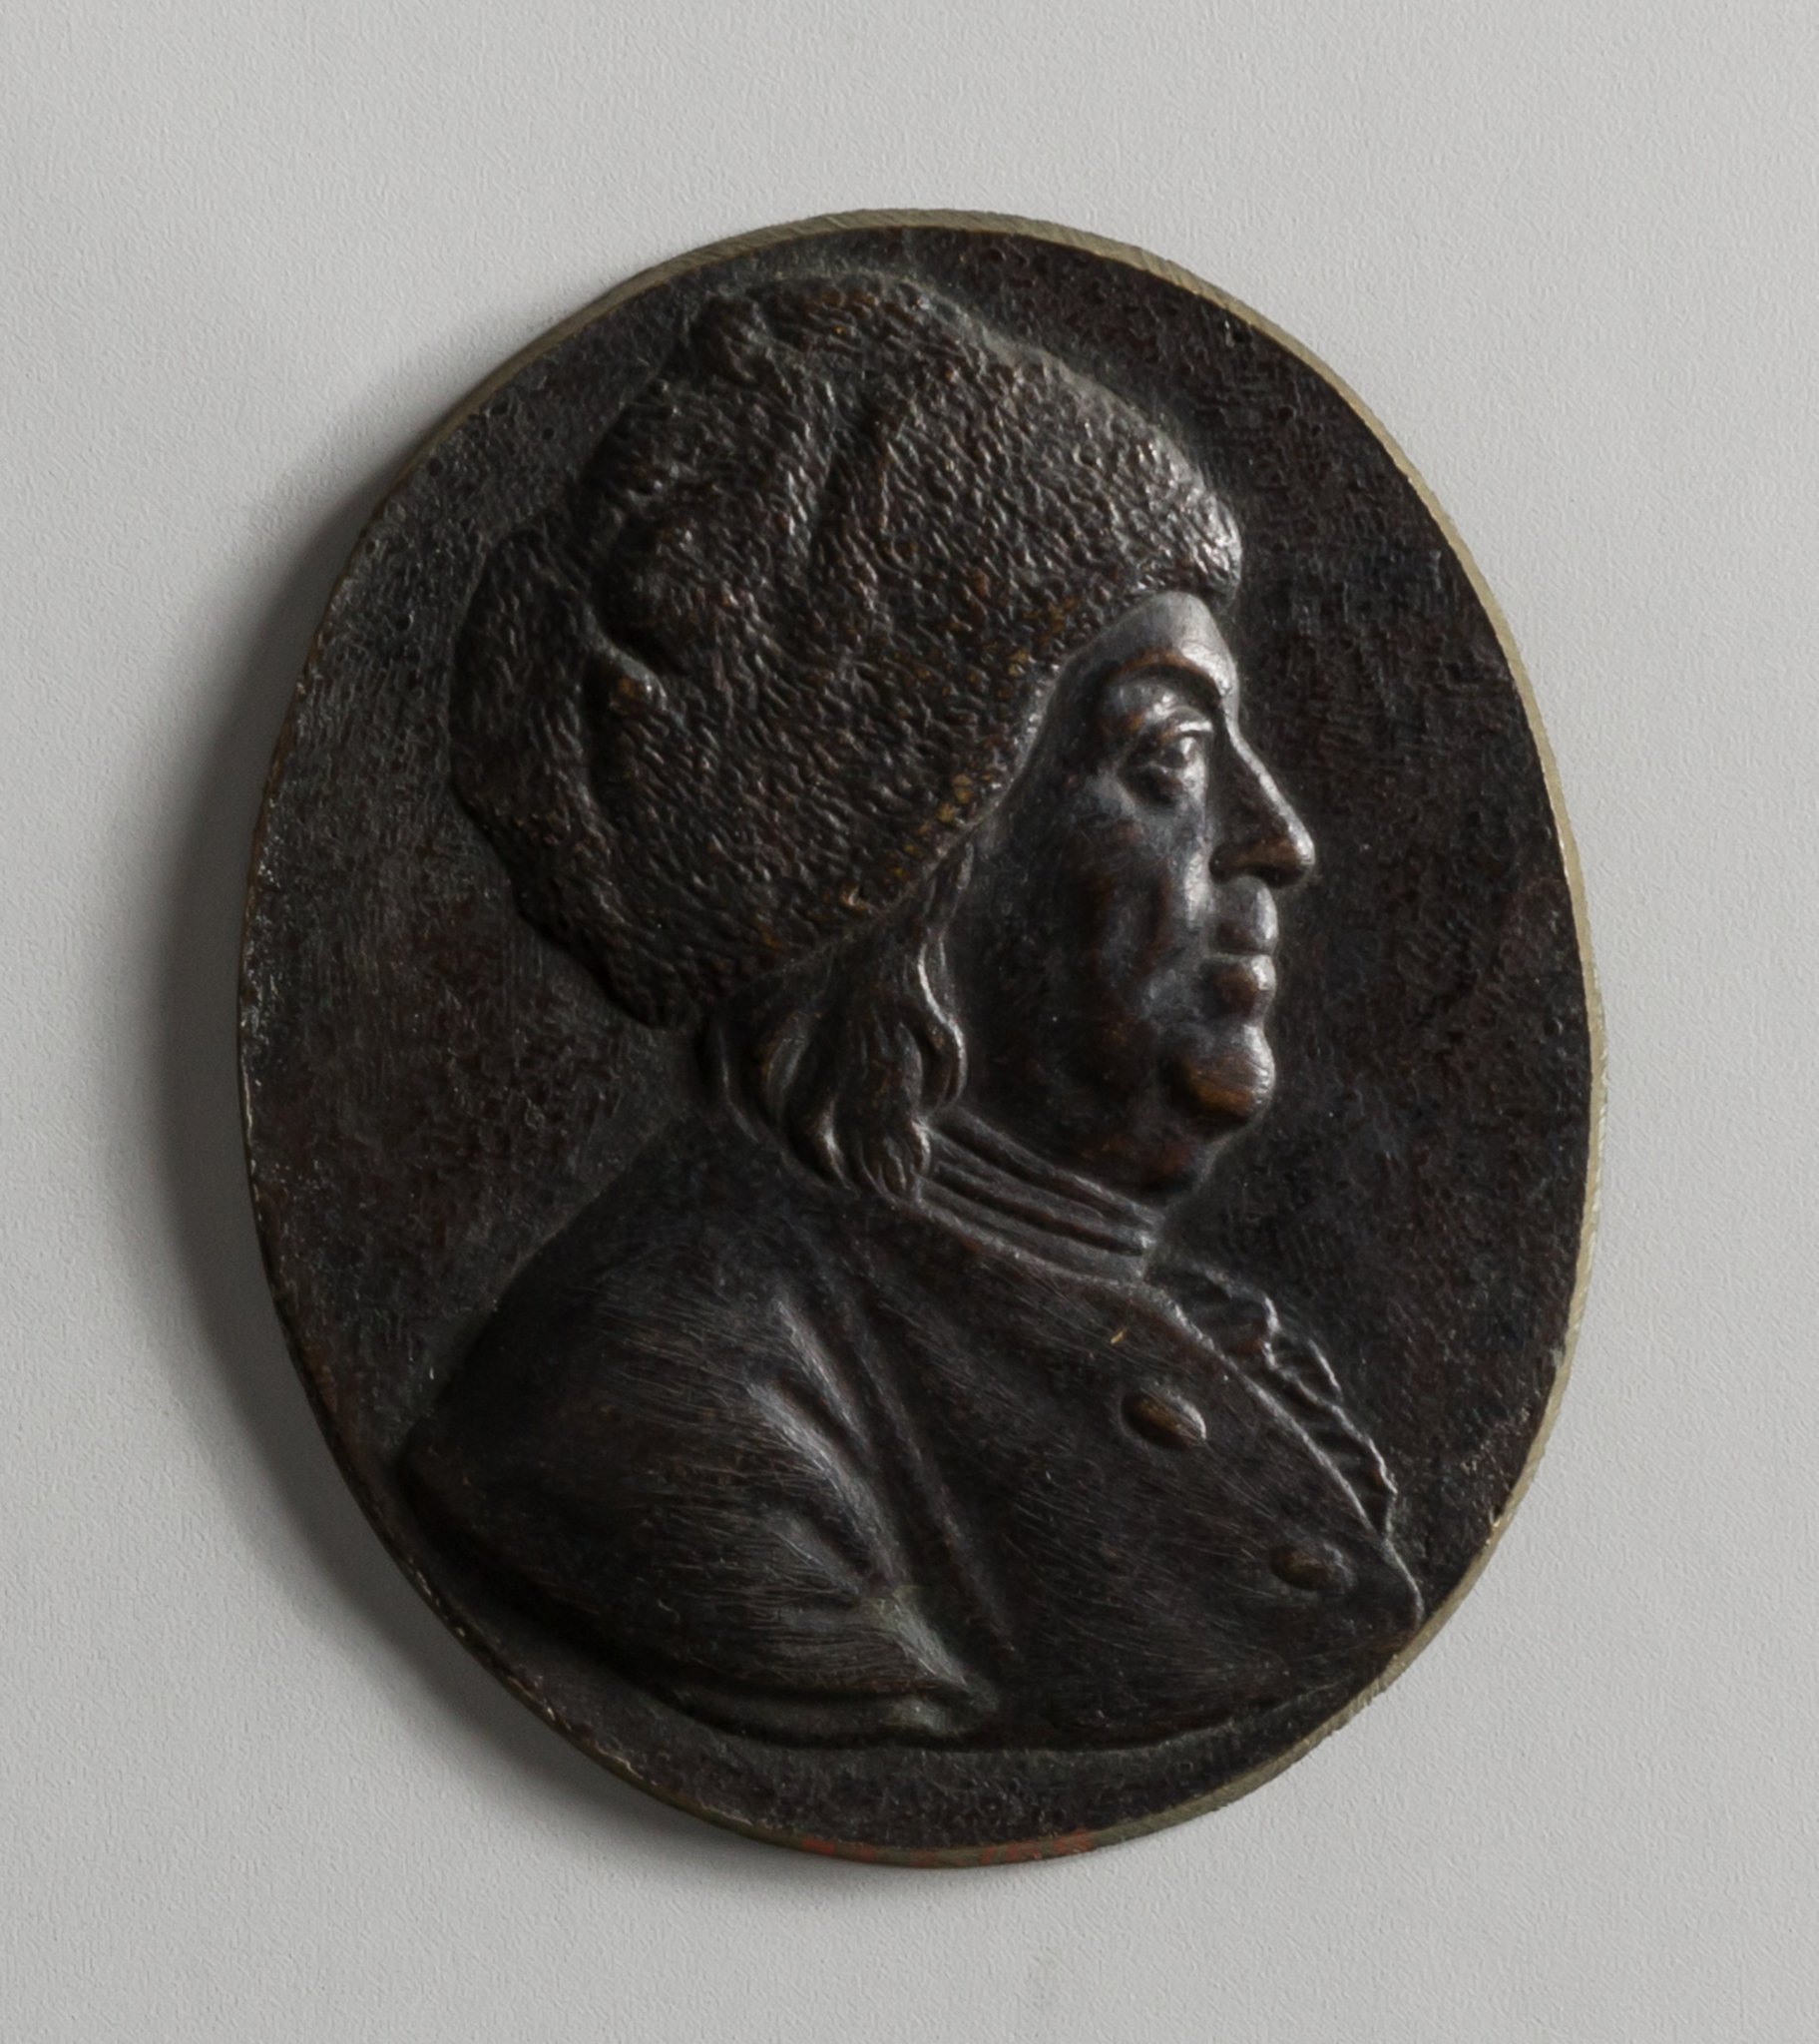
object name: medallion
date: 1776-1883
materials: bronze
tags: benjamin franklin,men,profiles